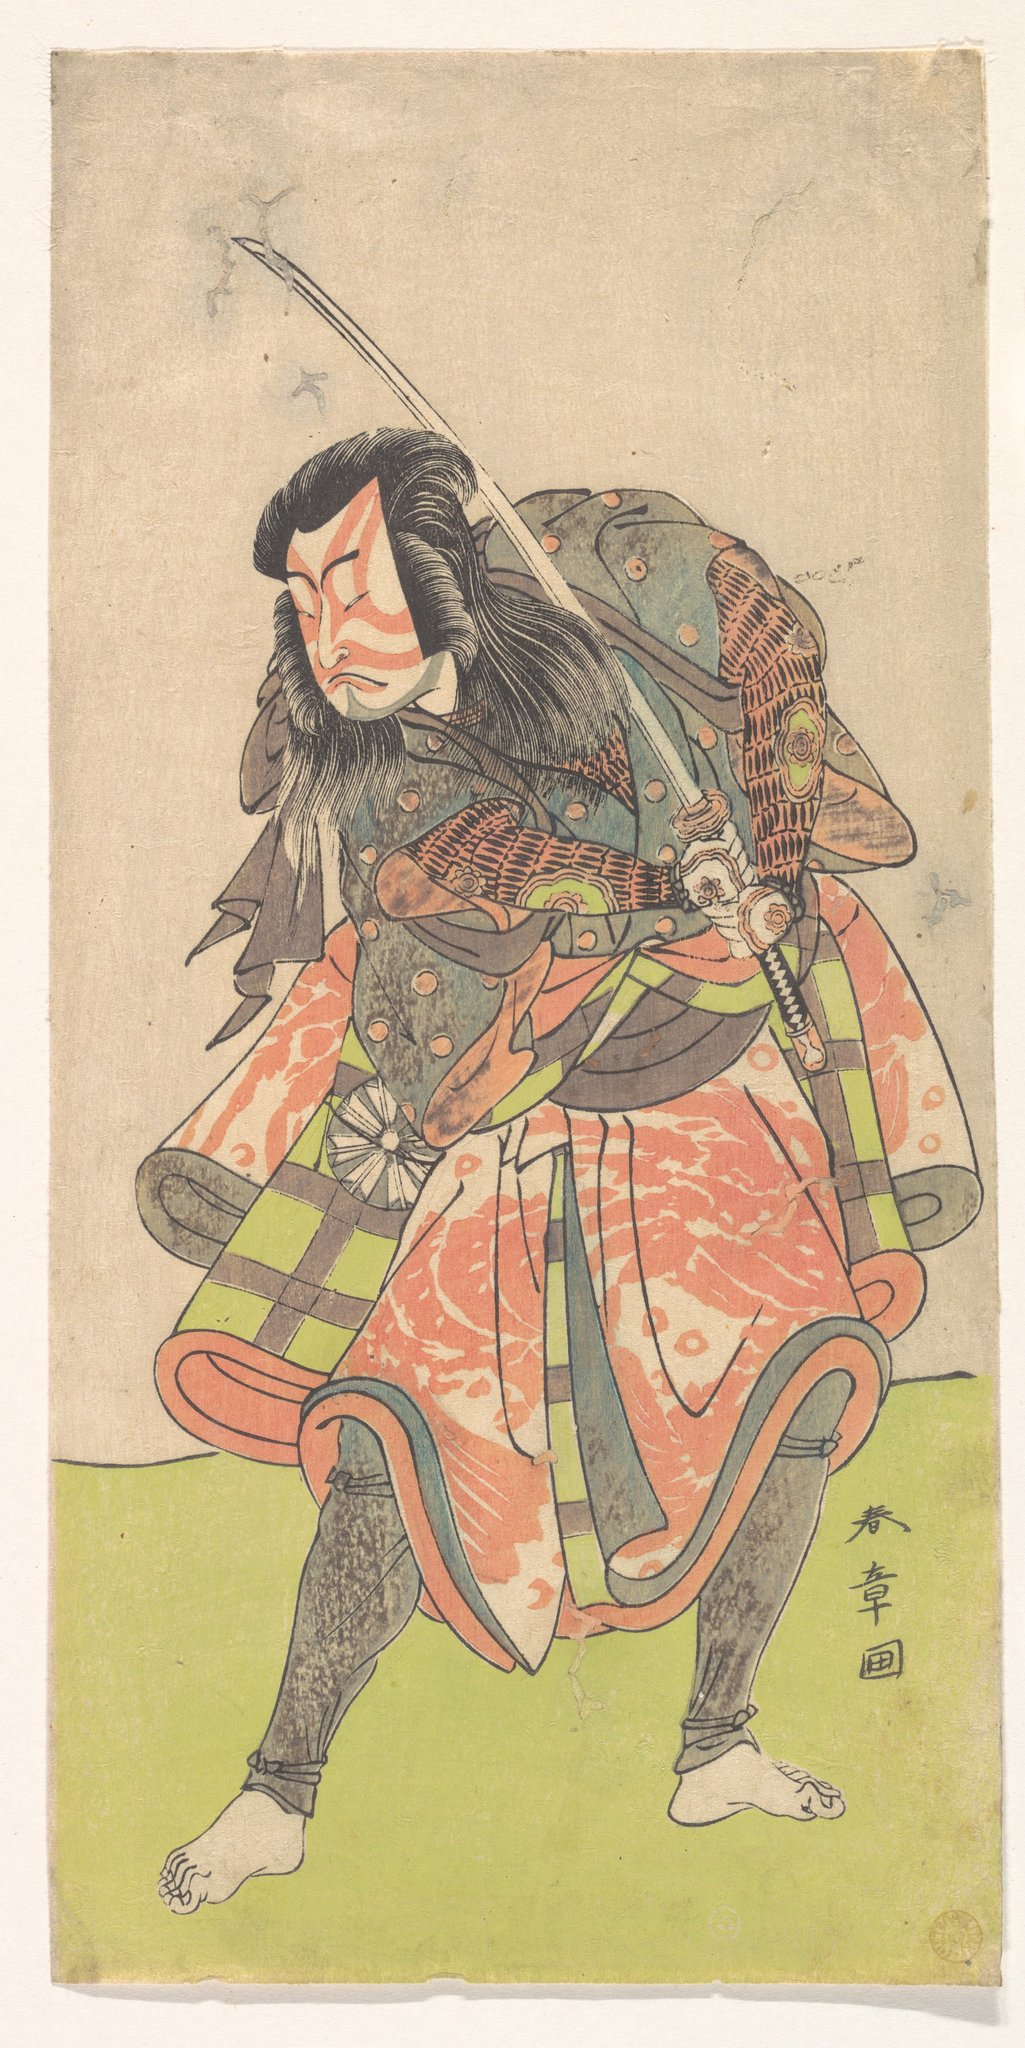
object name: woodblock print nishiki e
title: The First Nakamura Tomijuro as an Outlaw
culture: japanese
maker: katsukawa shunshō 勝川春章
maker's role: artist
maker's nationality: japanese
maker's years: 1726-1792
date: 1775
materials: ink, paper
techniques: nishiki e, woodblock print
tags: swords,actors